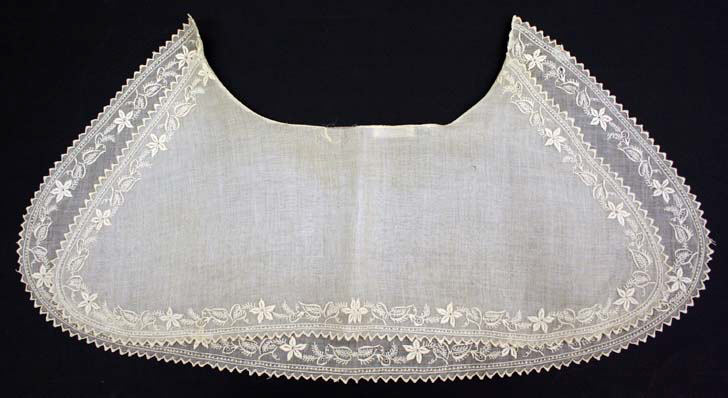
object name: collar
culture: american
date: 1830-1839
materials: linen